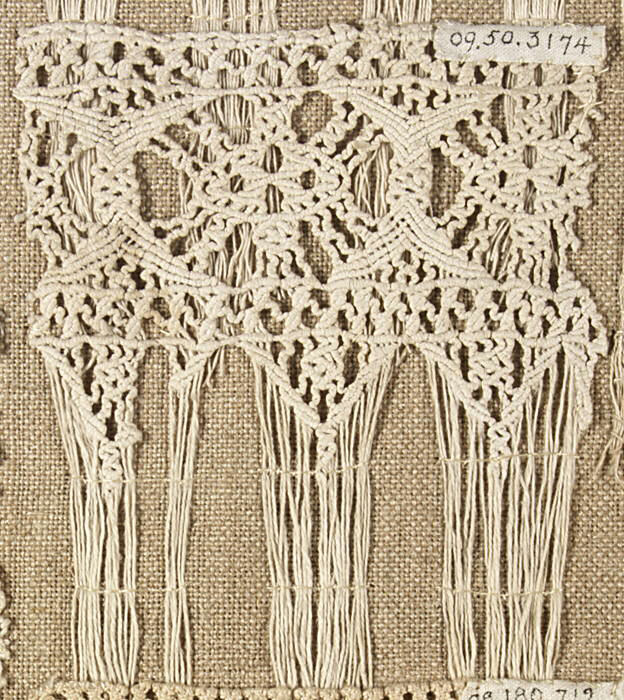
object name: fragment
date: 1601-1800